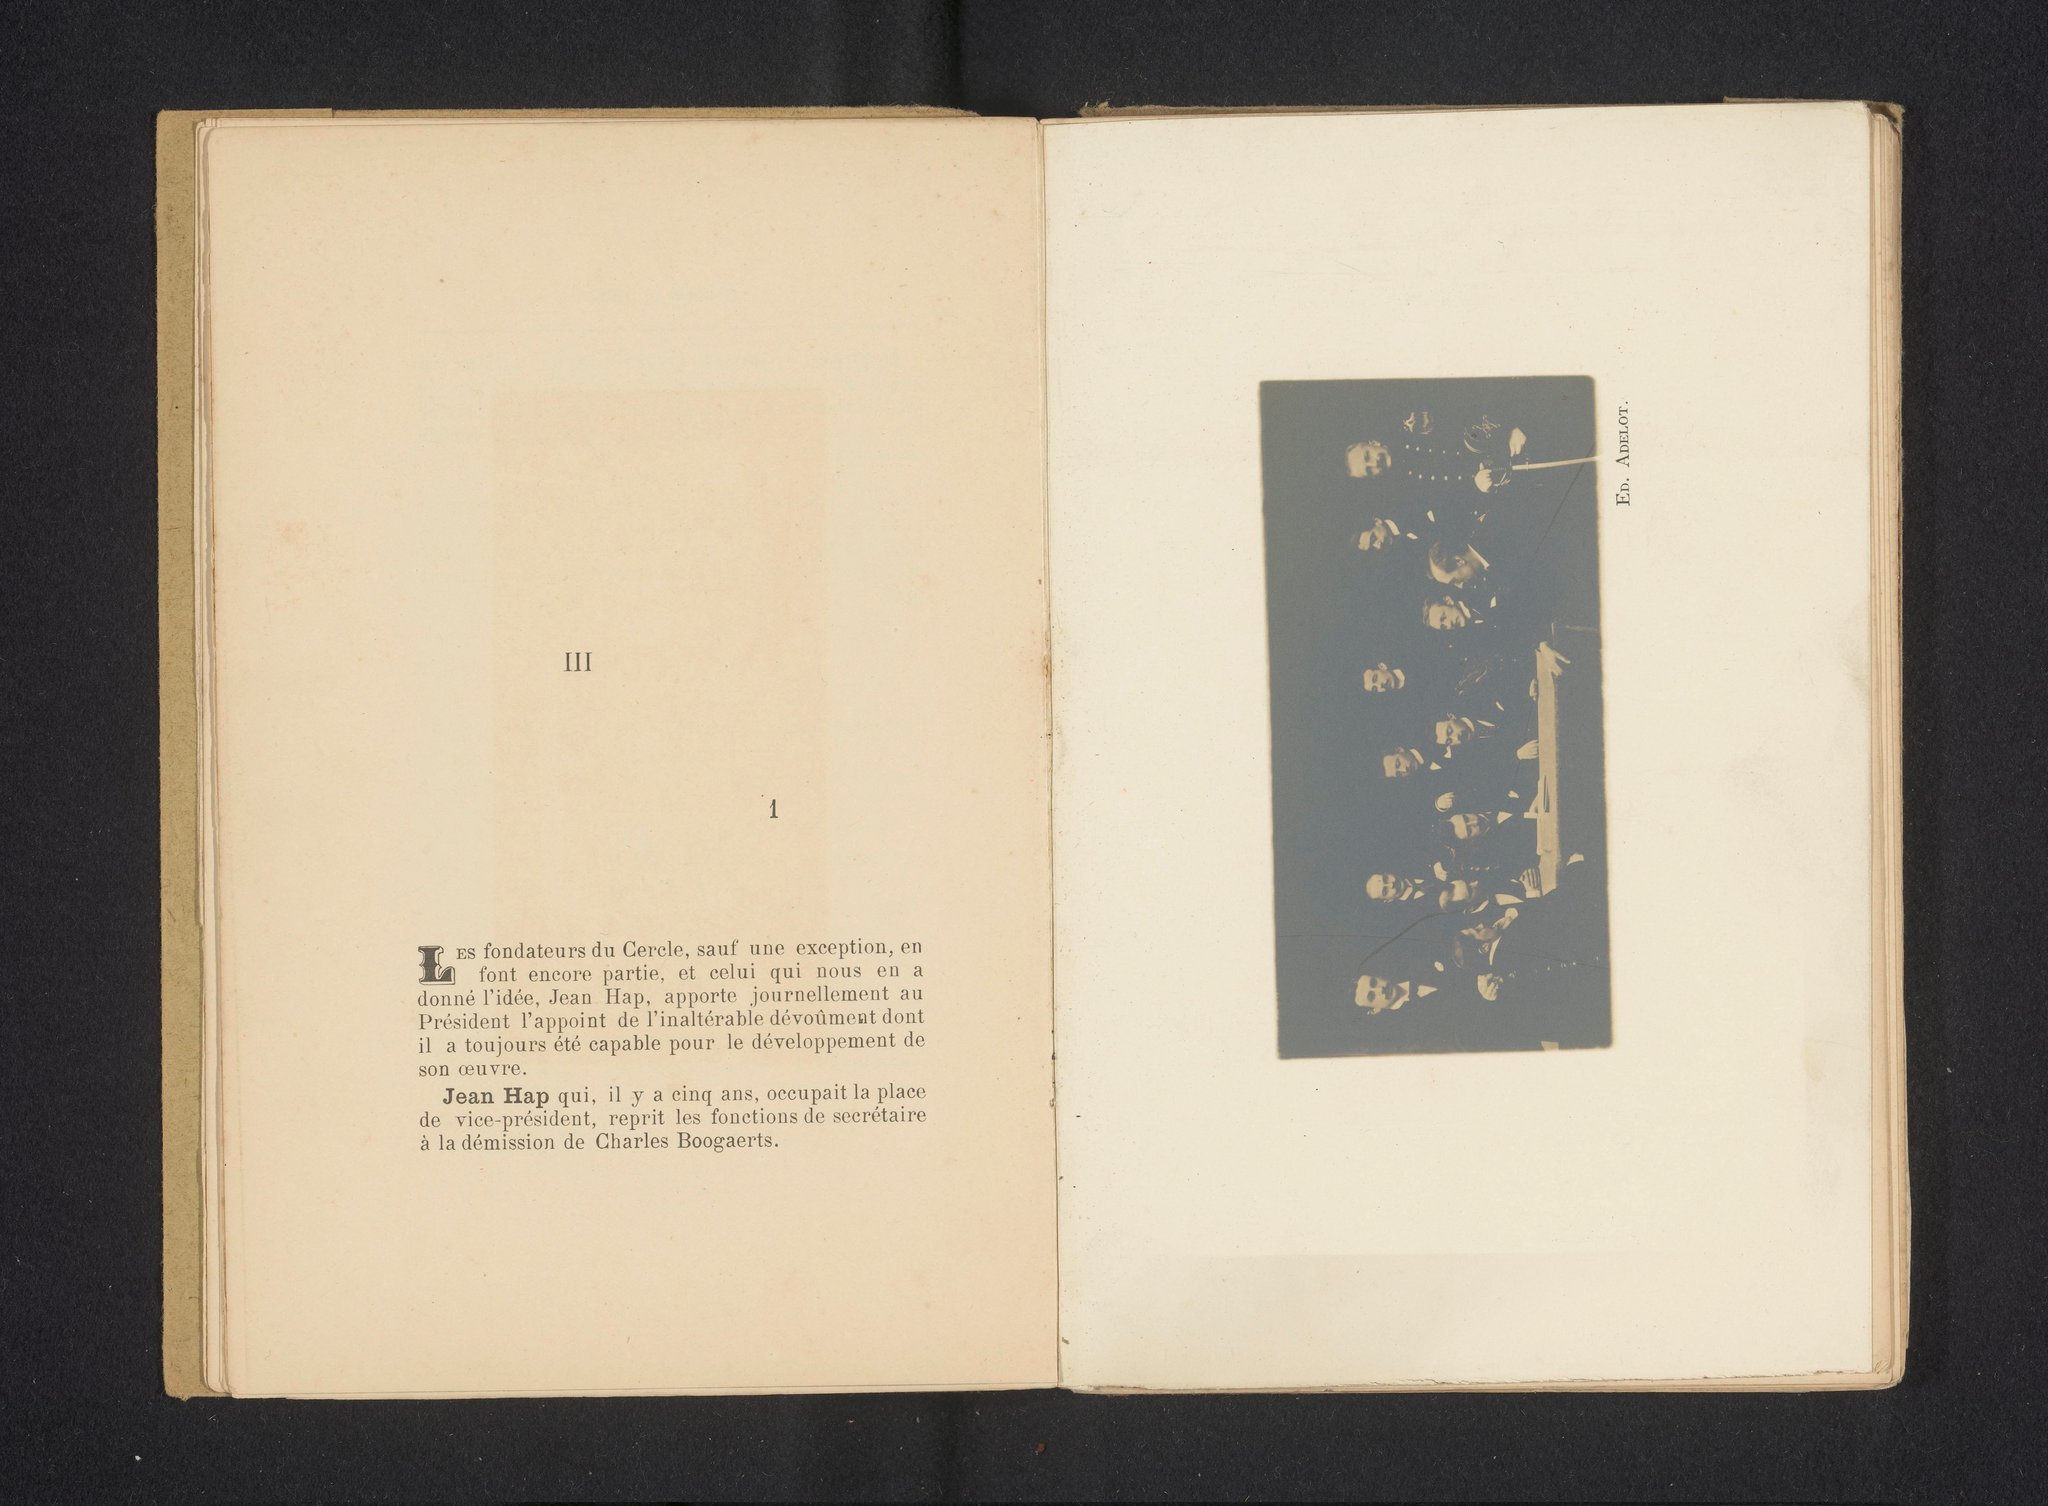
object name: page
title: Groepsportret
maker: edouard adelot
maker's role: fotograaf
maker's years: 1871-1937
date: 1896-1901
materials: photographic support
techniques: gelatin silver print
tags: anonymous historical persons portrayed in a group, in a group-portrait